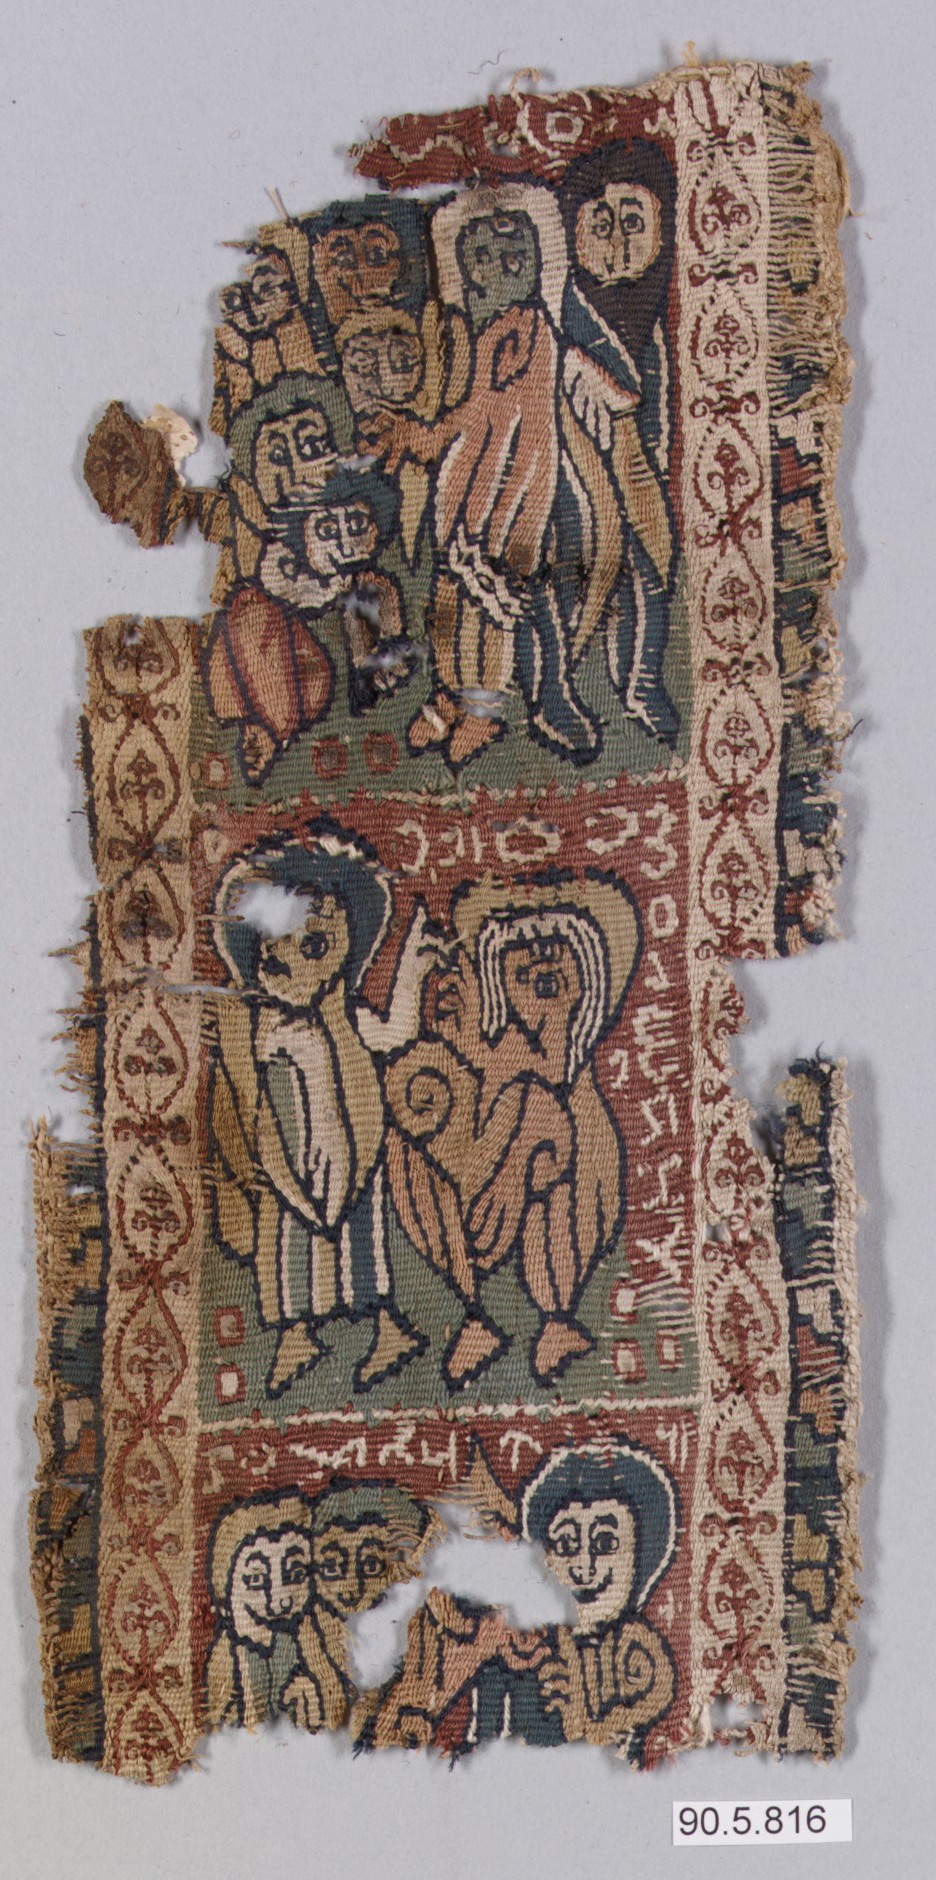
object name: textile fragment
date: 601-800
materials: linen, wool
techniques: weave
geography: egypt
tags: human figures